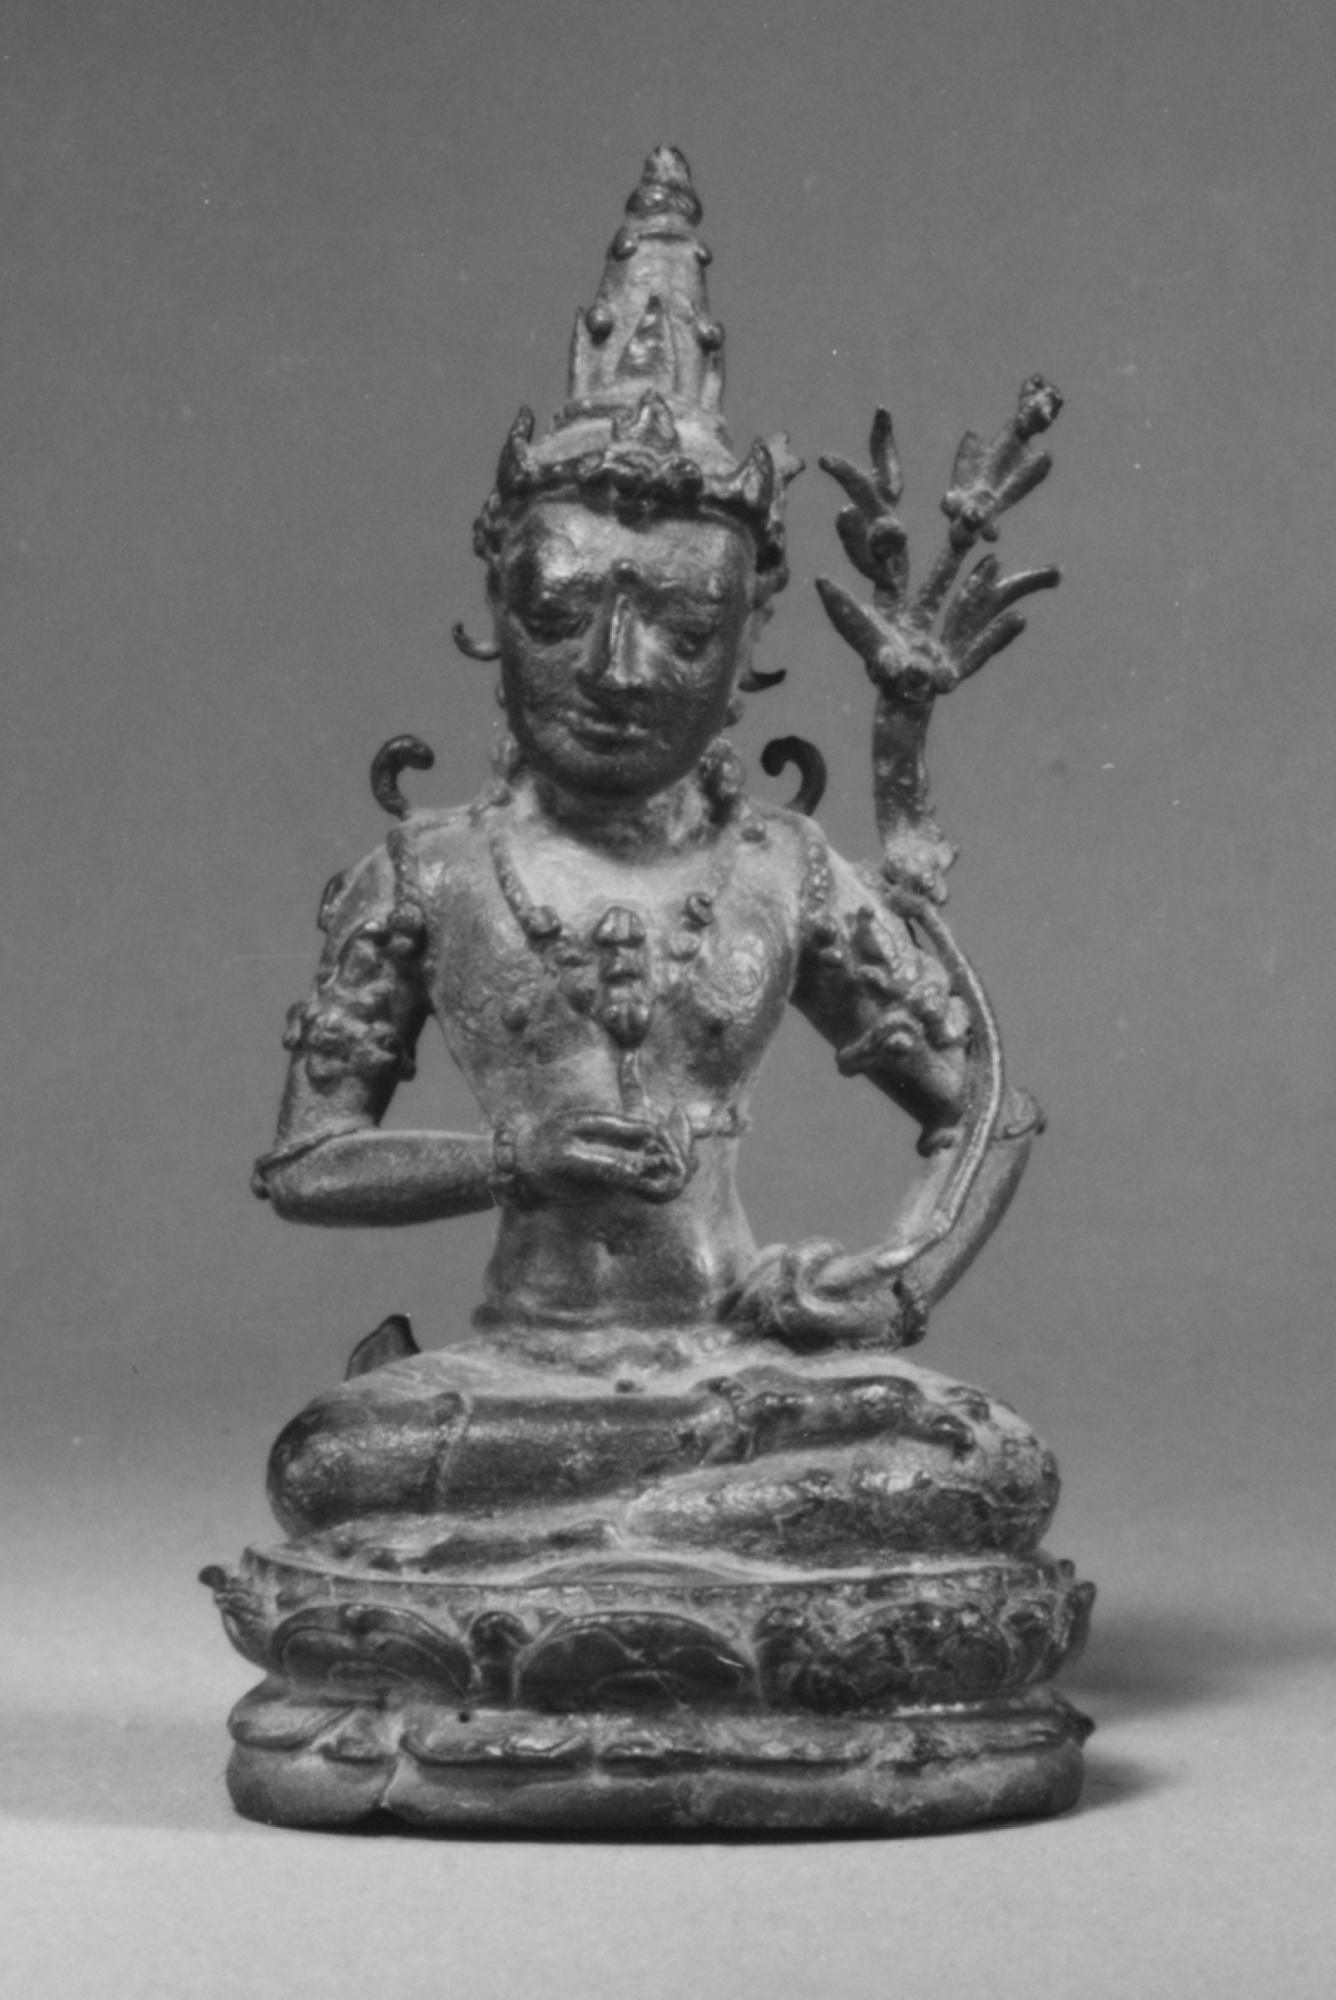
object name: figurine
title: Seated Male Deity Supporting a Vajra on His Finger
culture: indonesian, java, ngandjuk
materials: bronze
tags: deities